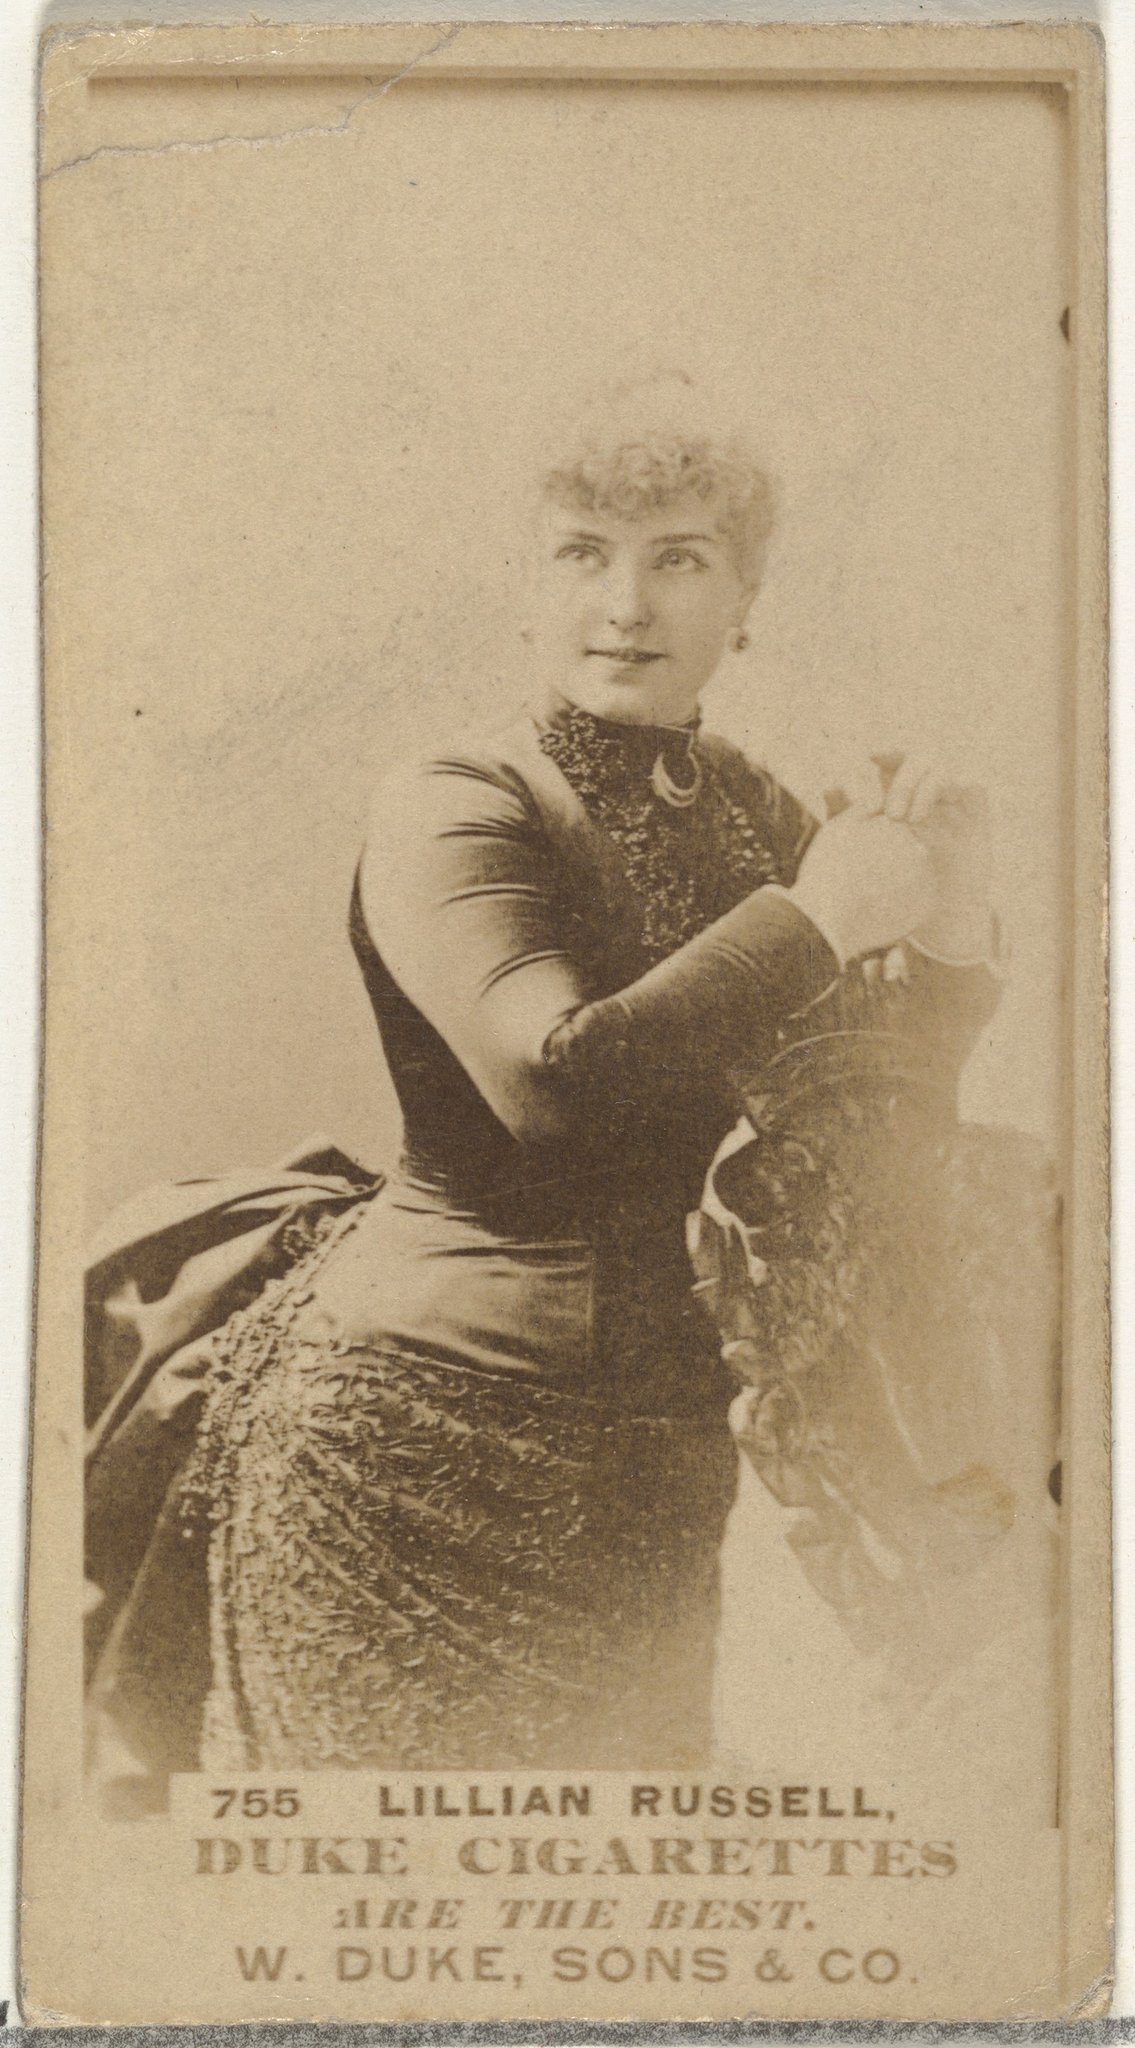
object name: photograph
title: Card Number 755, Lillian Russell, from the Actors and Actresses series (N145-7) issued by Duke Sons & Co. to promote Duke Cigarettes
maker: w. duke, sons & co.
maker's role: publisher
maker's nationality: american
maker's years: 1870-1920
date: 1880-1889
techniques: albumen silver print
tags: portraits,women,actresses